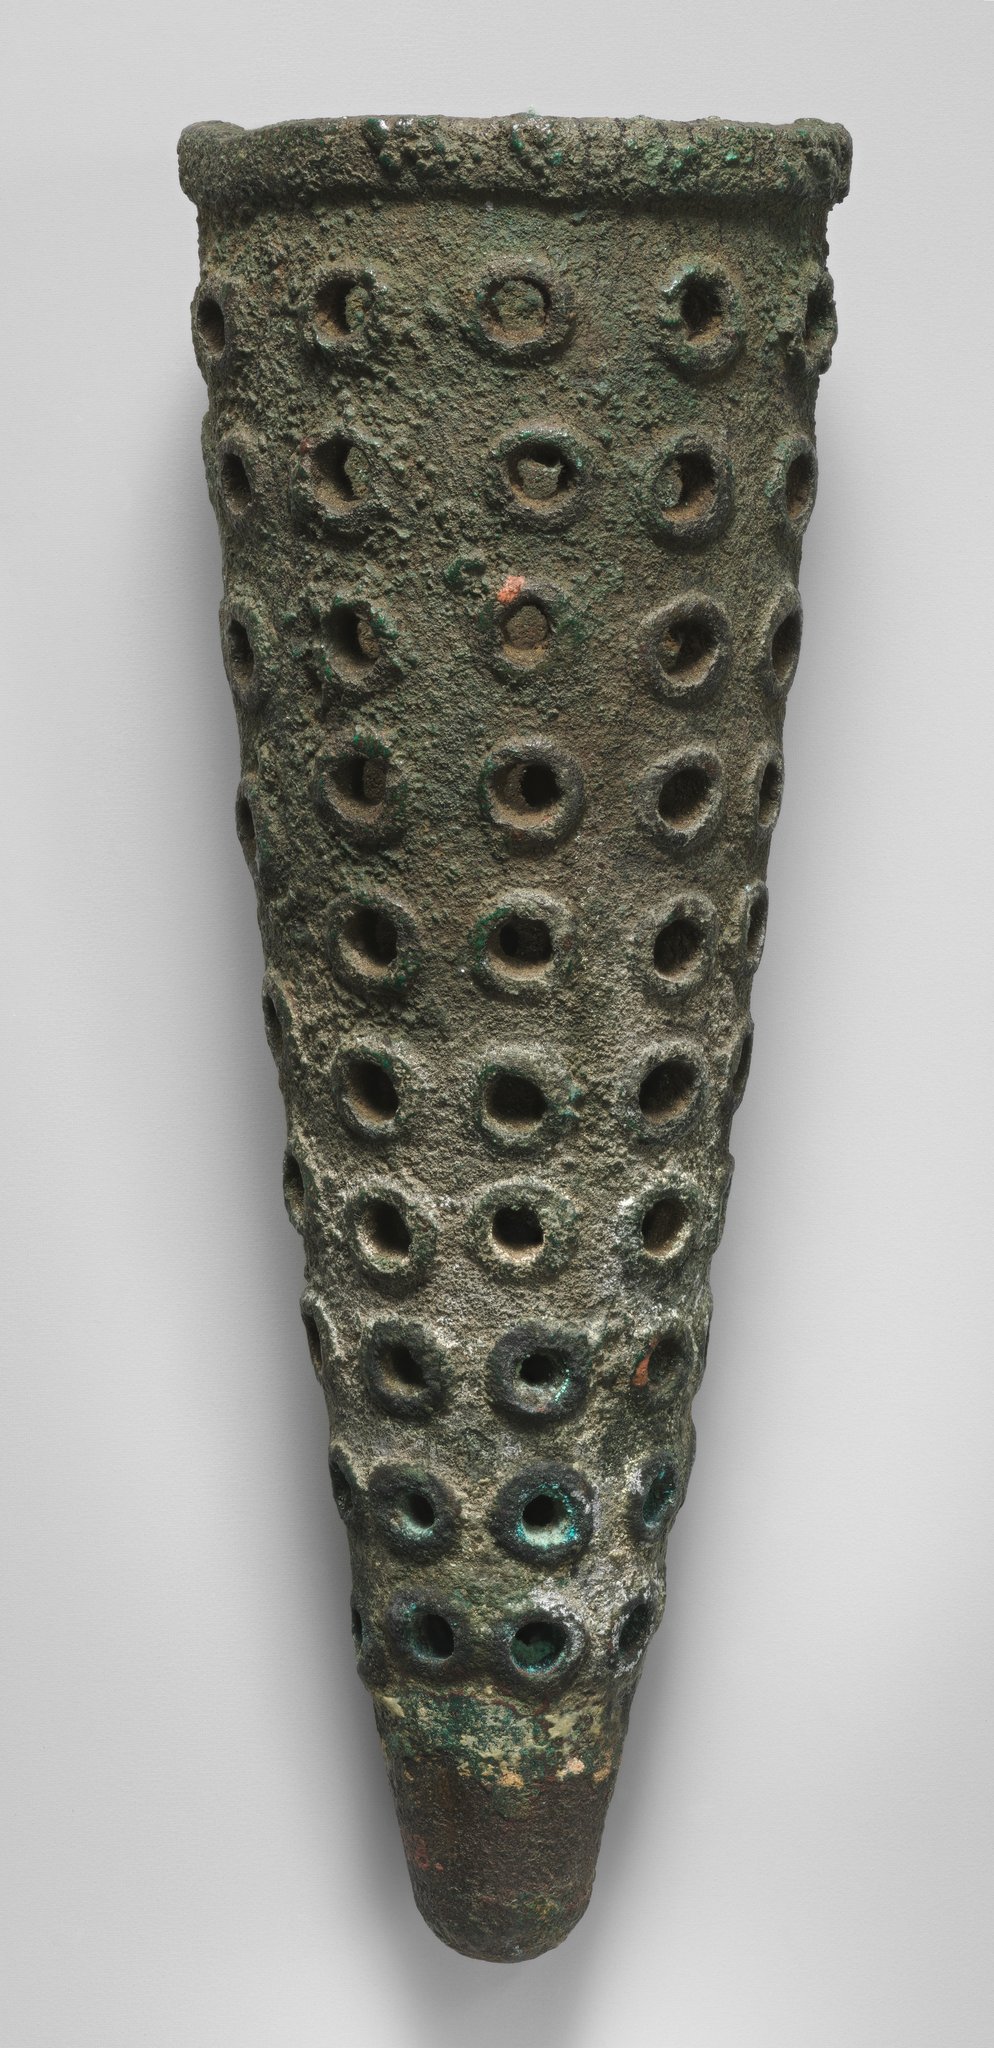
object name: strainer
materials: bronze, copper alloy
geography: egypt